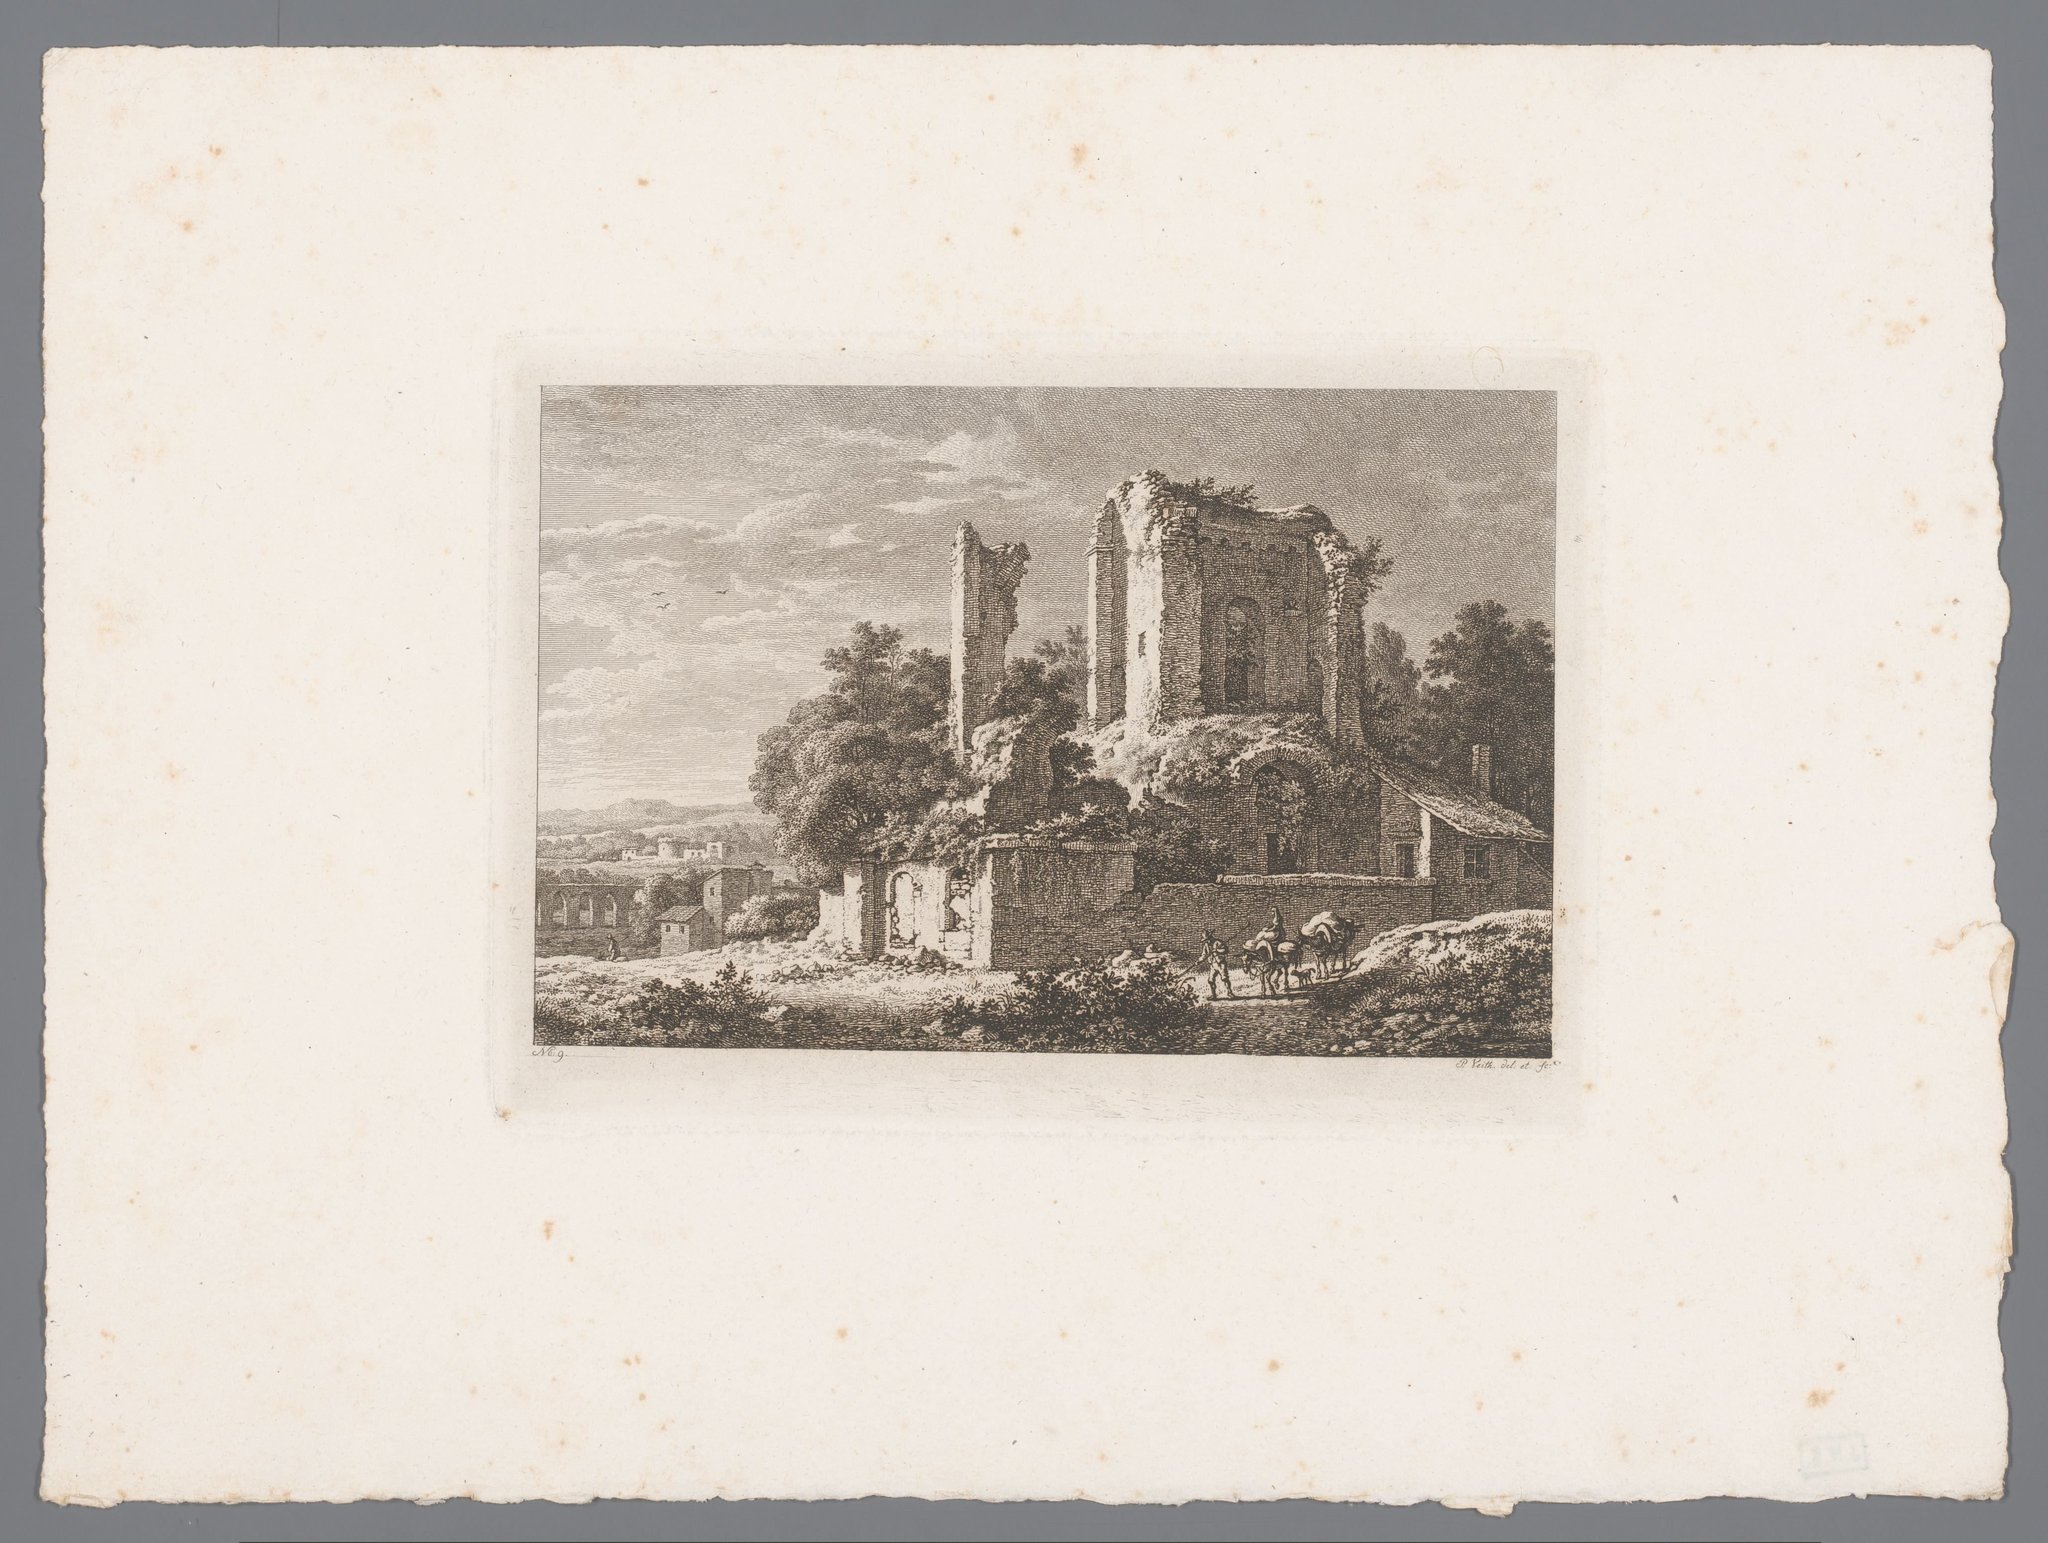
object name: print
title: Bezigheden in de vrije tijd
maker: philipp veith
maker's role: draughtsman, print maker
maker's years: 1768-1837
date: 1822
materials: paper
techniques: etching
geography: dresden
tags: city-view, and landscape with man-made constructions, ass, donkey, landscape with ruins, 'en route', traveller under way, rome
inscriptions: collector's mark: Lugt 2760, collector's mark: Lugt 2228, collector's mark: Lugt 3976